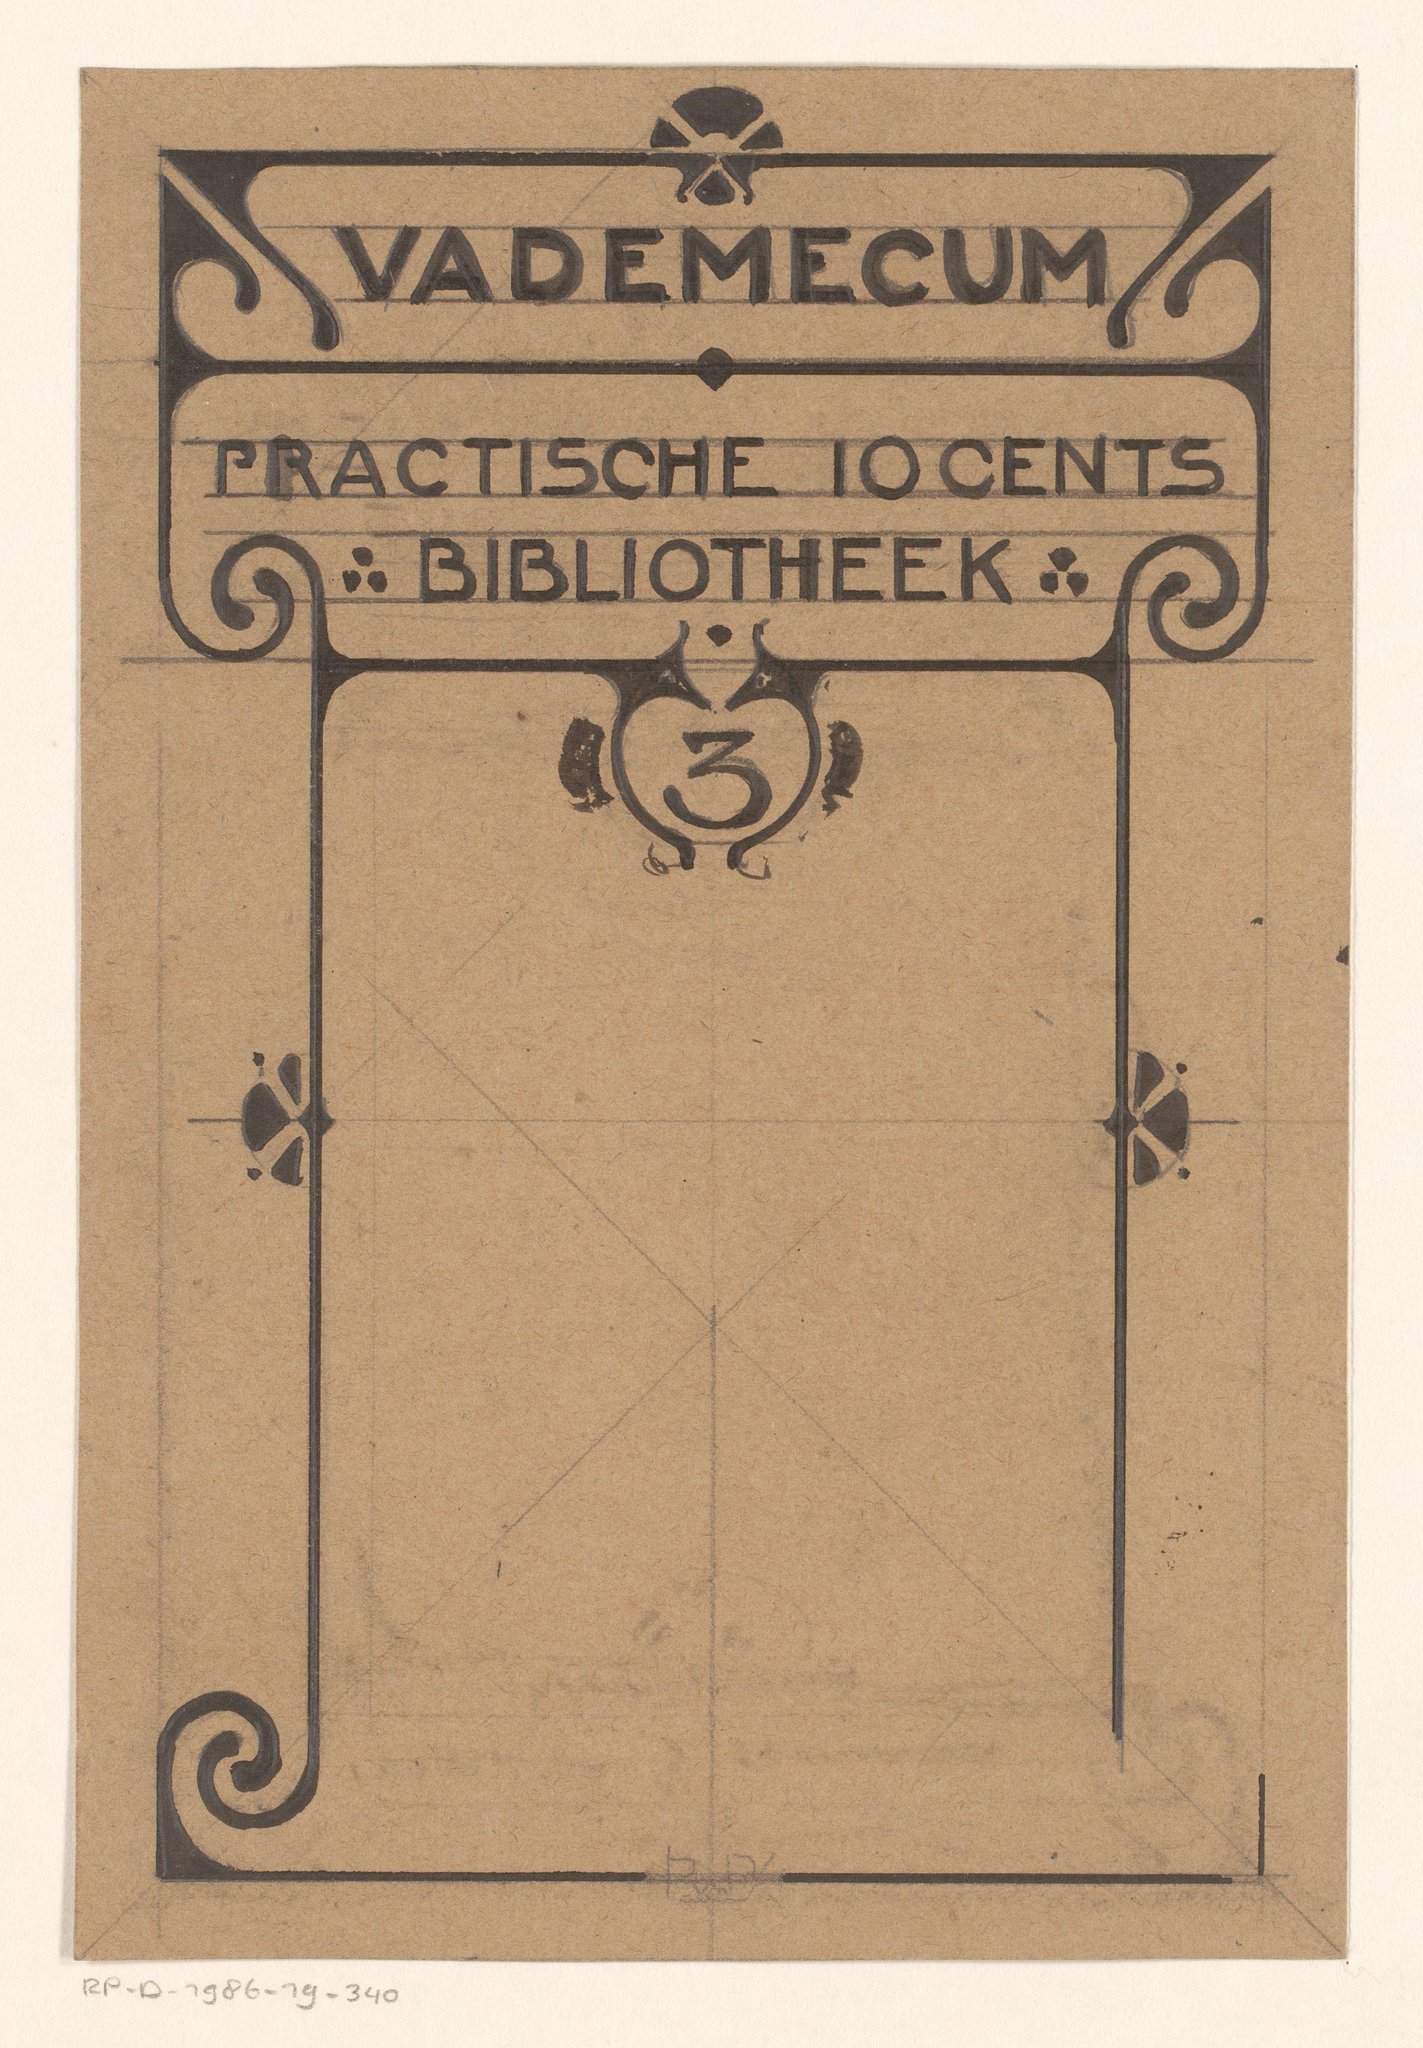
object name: drawing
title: Omslagontwerp voor: Vademecum. Praktische 10 cents bibliotheek, 1903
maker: reinier willem petrus de vries (1874-1953)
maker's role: draughtsman, print maker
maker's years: 1874-1953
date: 1903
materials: ink, paper, pencil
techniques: brush, pen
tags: ornament ~ spiral and derived from spiral, e.g.: greek wave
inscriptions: collector's mark: ‘R:MVS.’